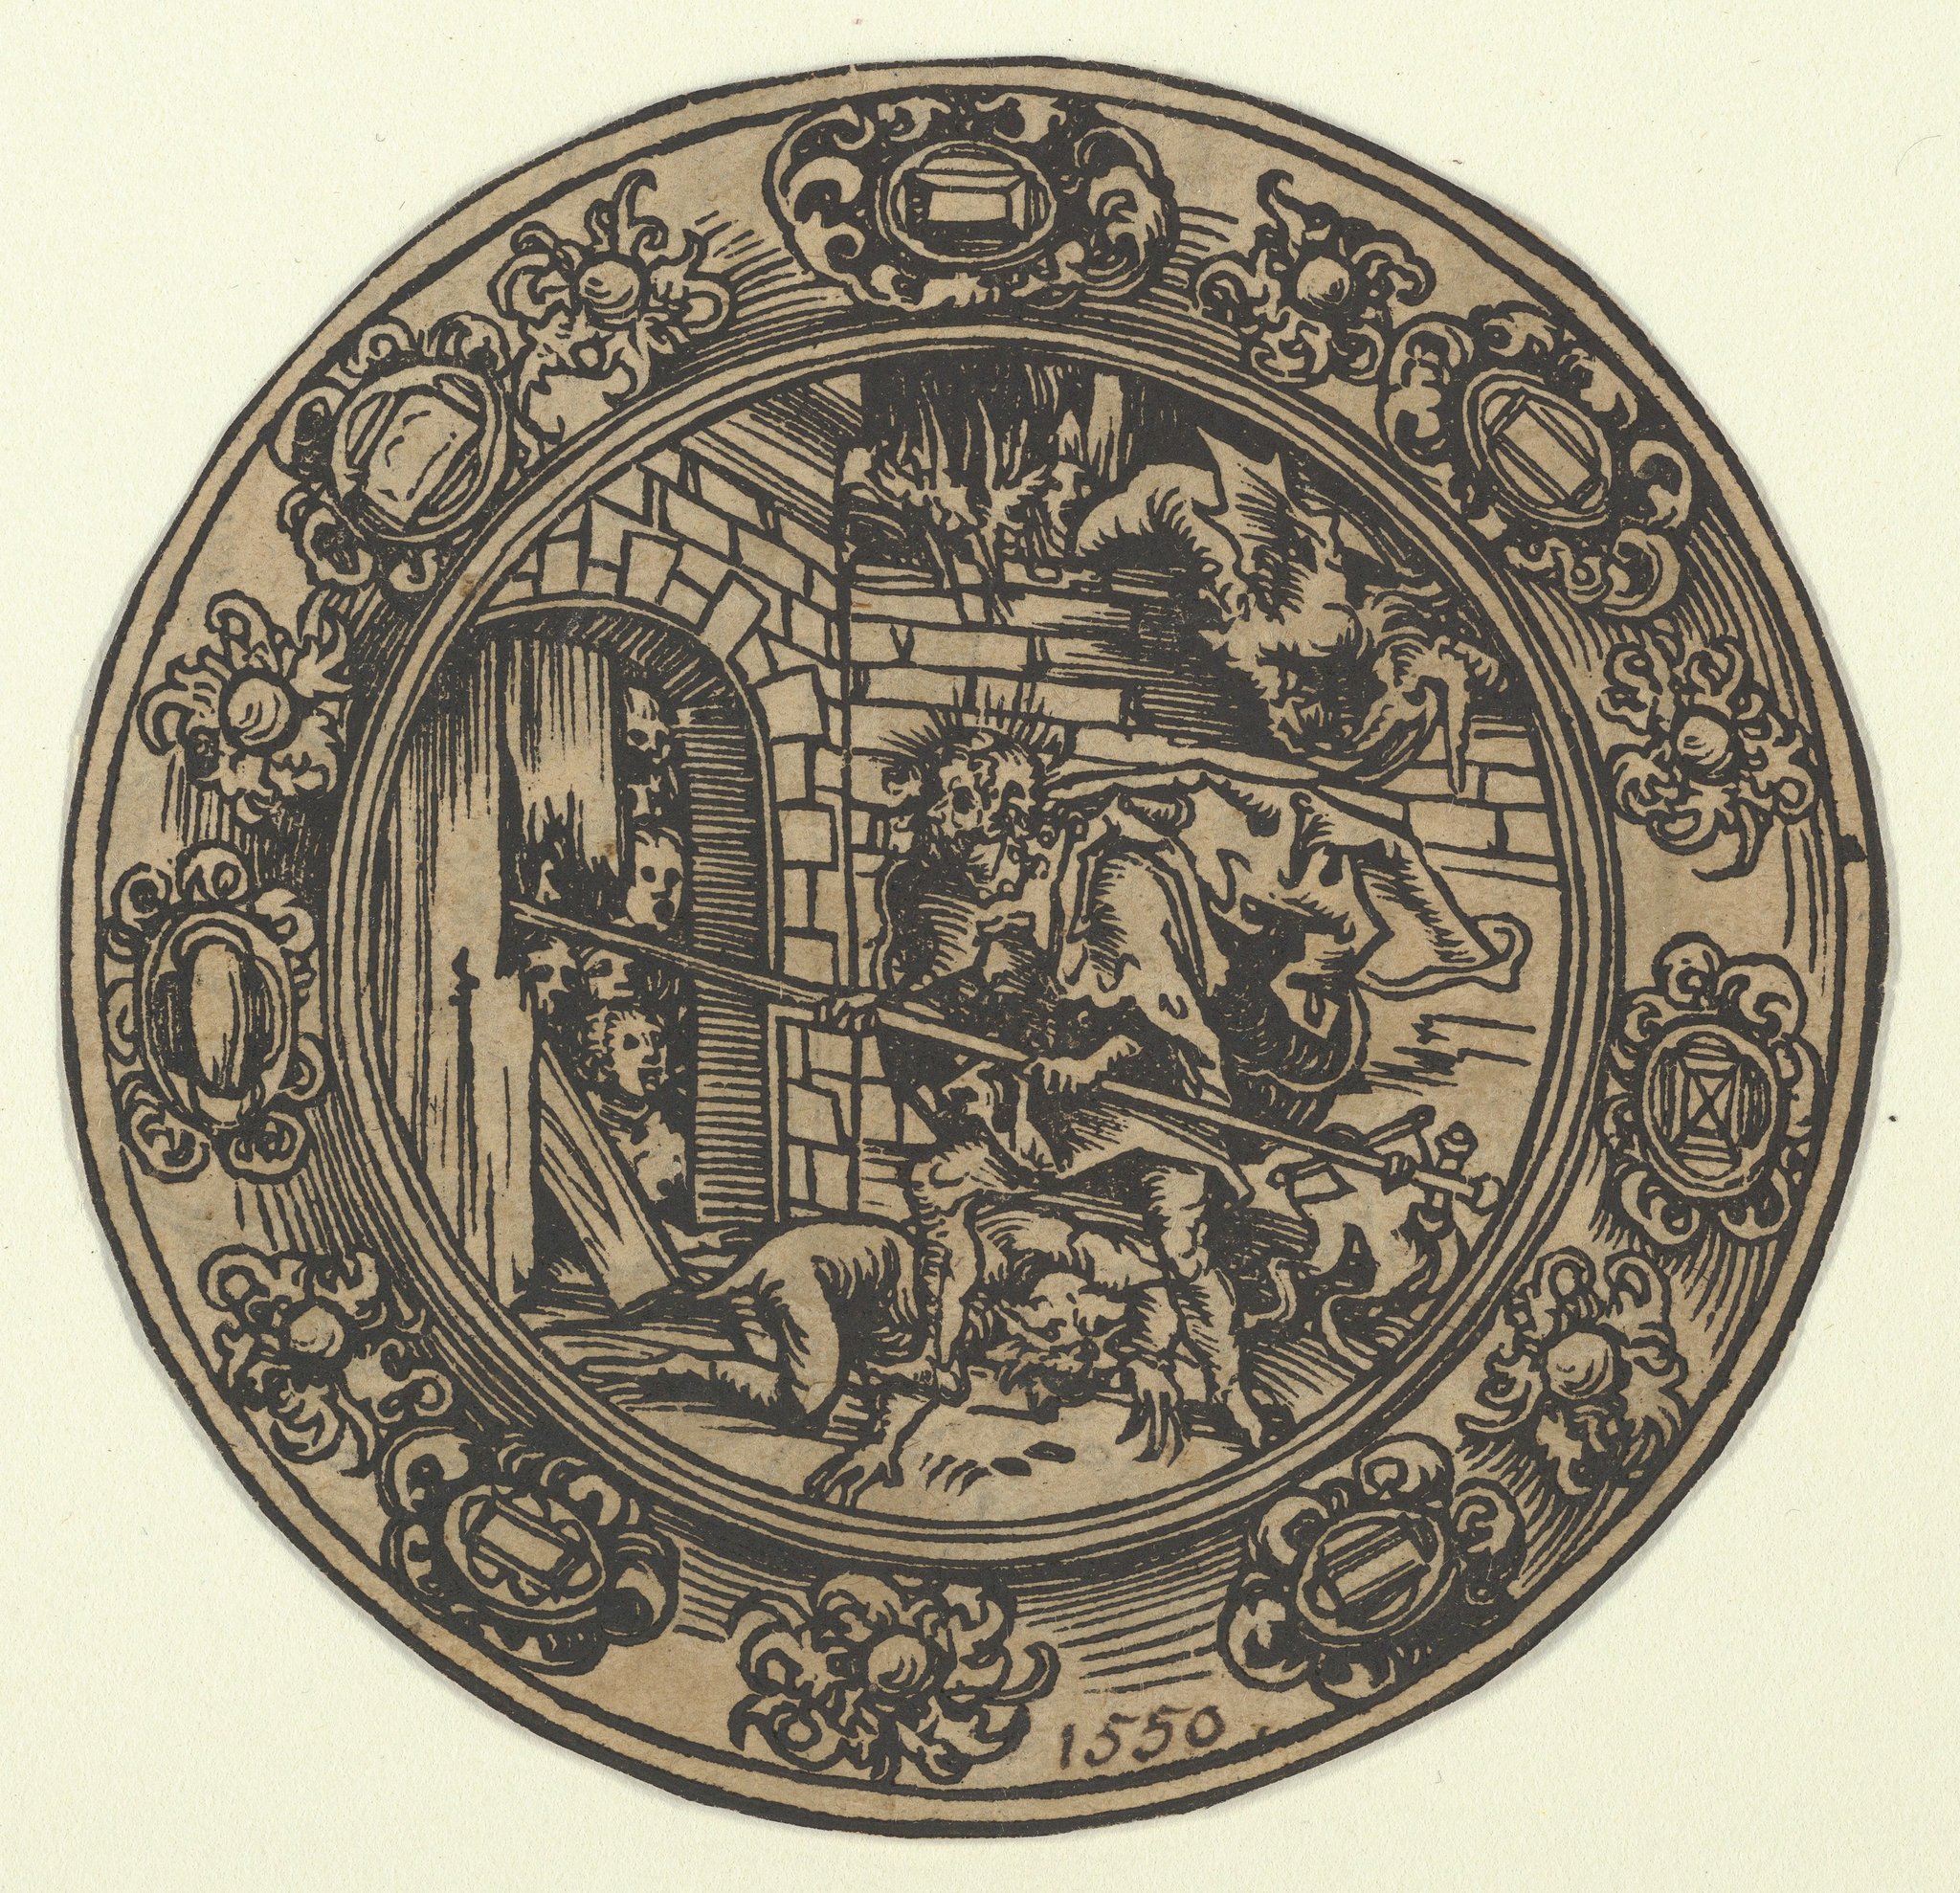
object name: print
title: Pacifical-medaillon with Christ in Limbo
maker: lucas cranach the elder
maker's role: artist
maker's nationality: german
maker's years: 1472-1553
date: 1472-1553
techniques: woodcut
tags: christ